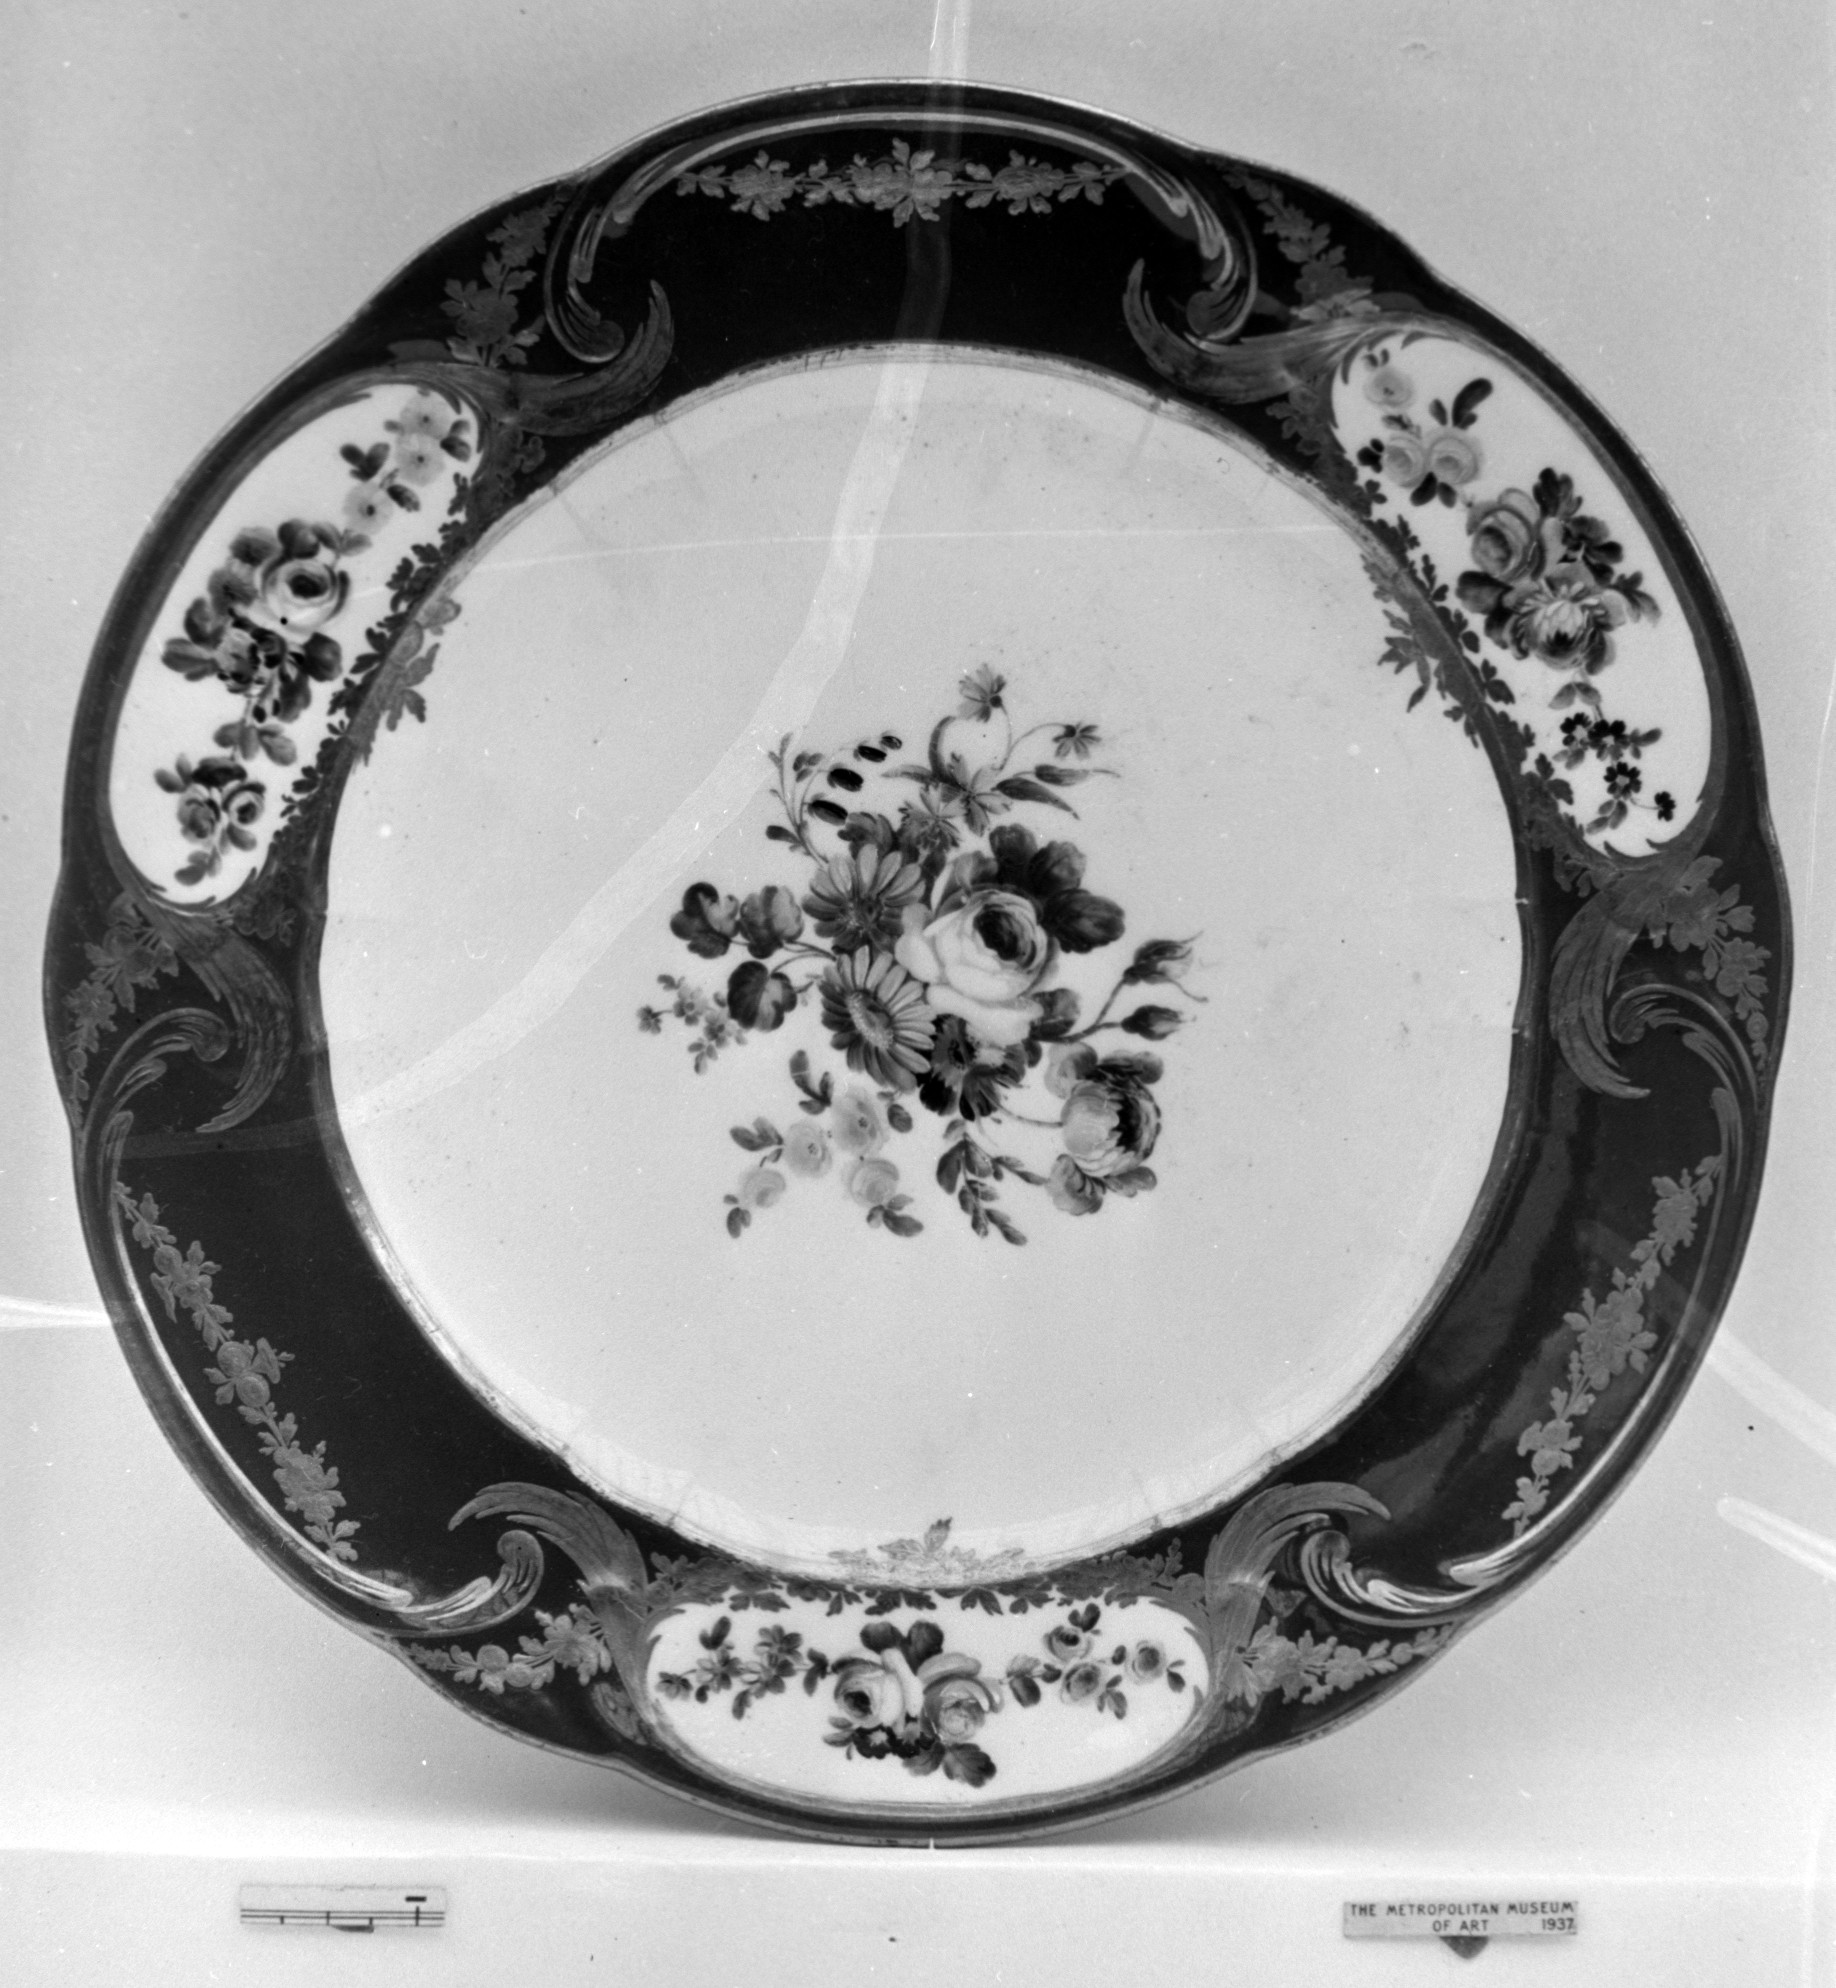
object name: plate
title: Plate (Assiette à palmes) (1 of 102) (part of a service)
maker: sèvres manufactory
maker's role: manufactory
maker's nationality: french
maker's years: 1740-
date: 1772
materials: soft paste porcelain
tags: flowers